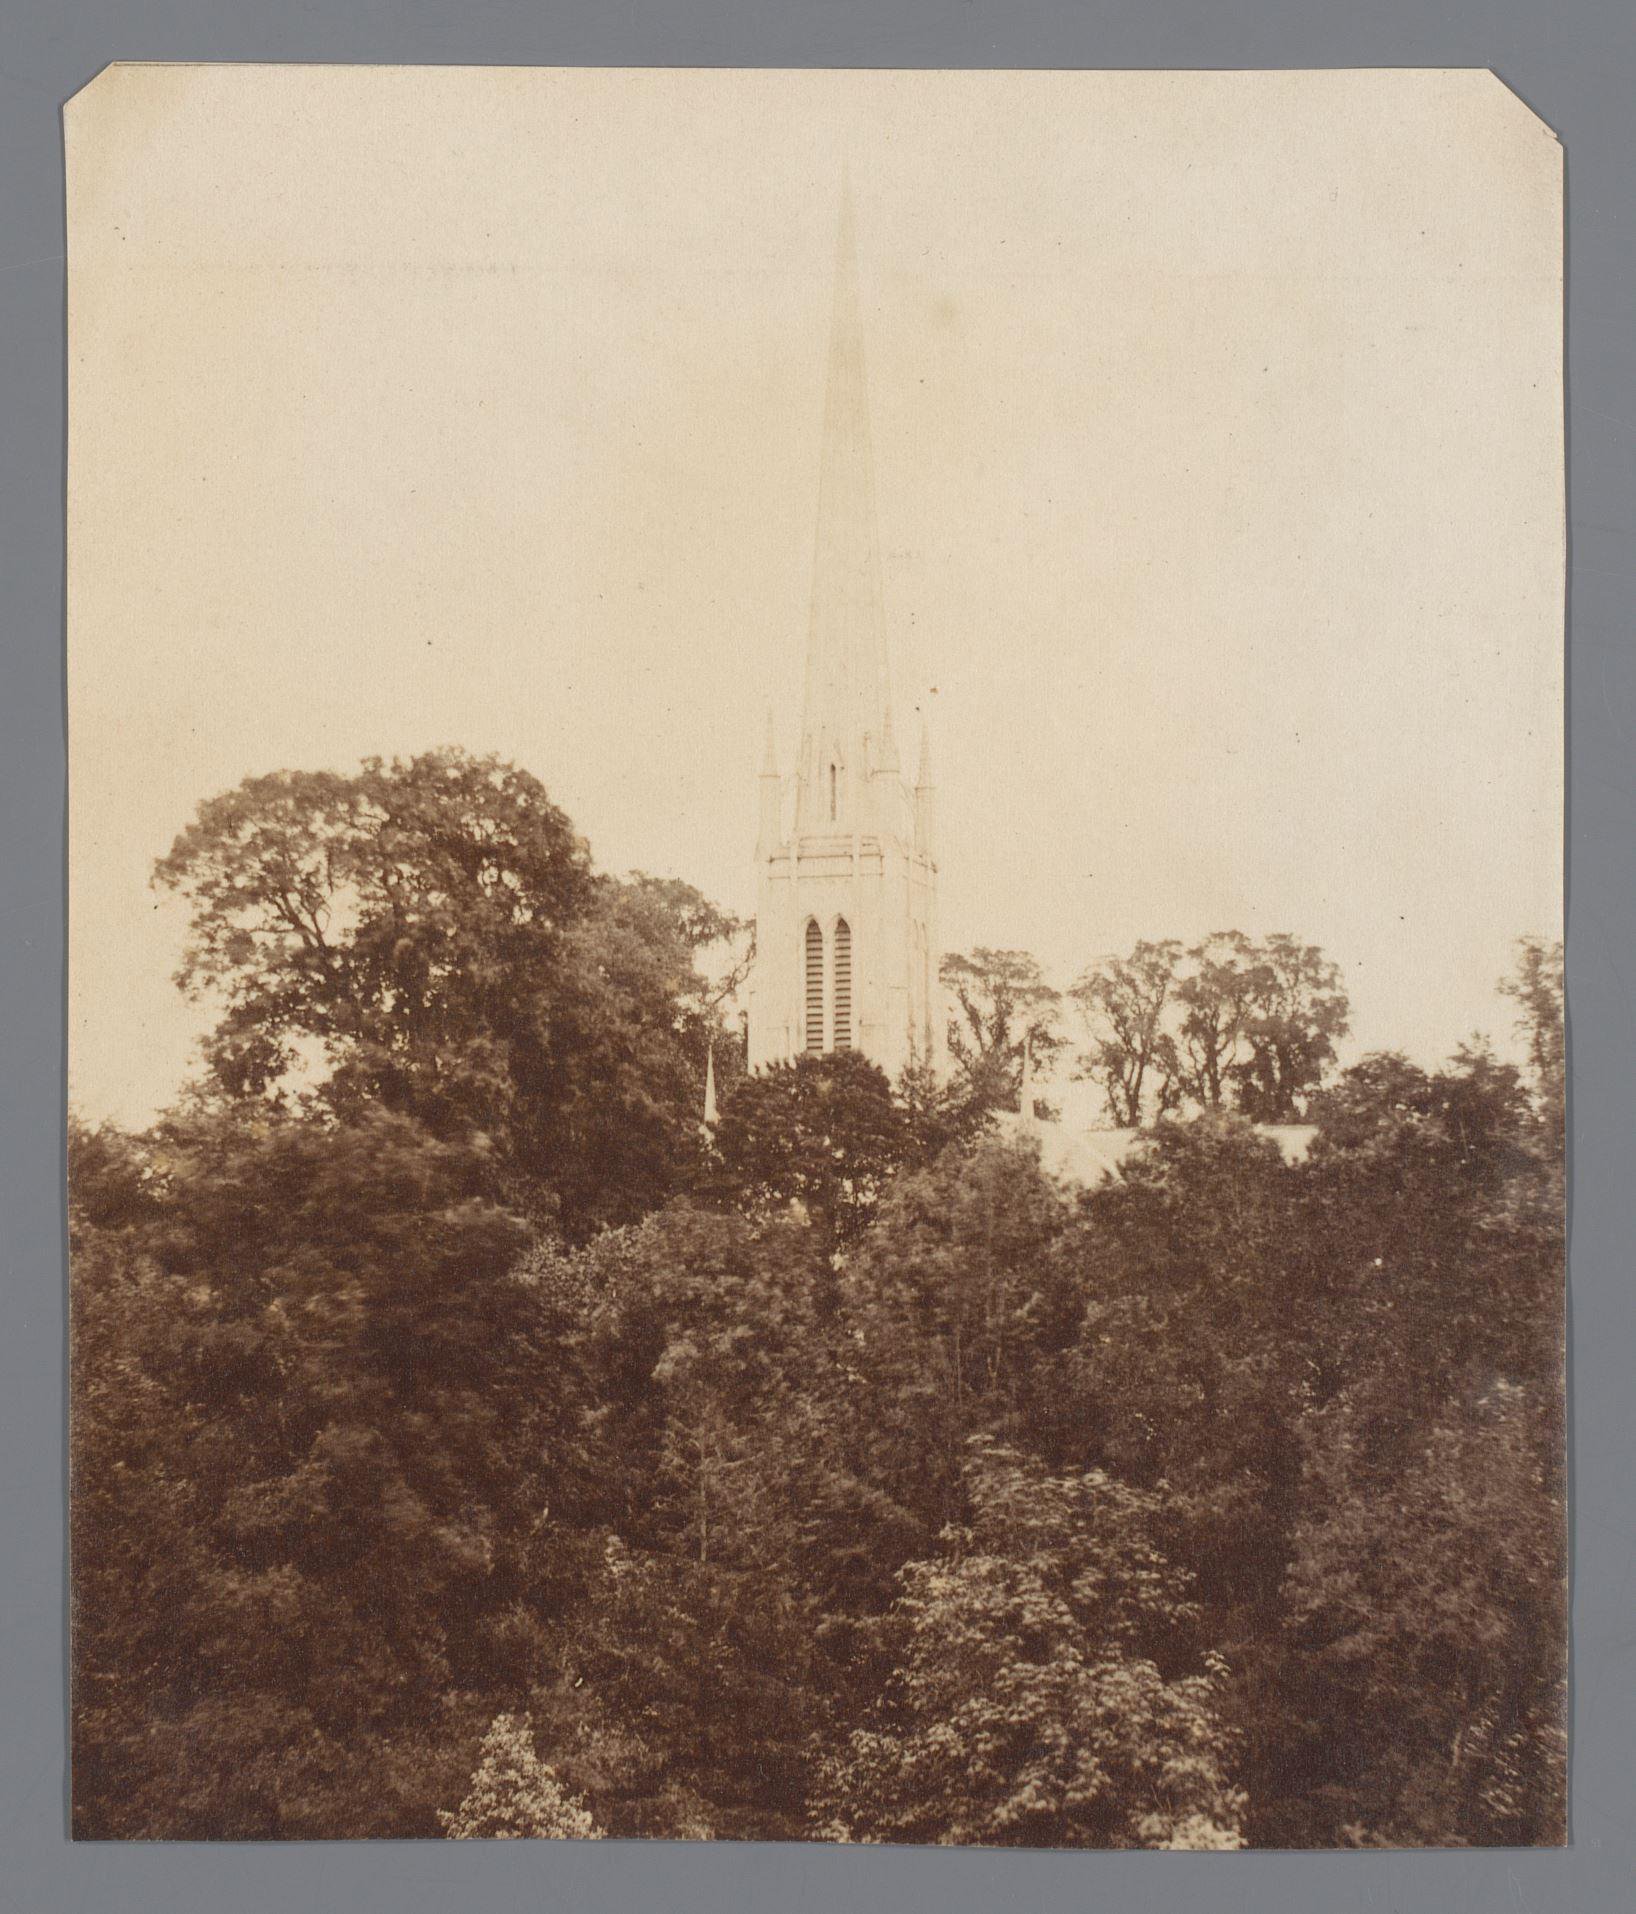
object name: photograph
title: Kerktoren boven de bomen van een bos of park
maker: Anonymous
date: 1875-1890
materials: paper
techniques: albumen print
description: Kerktoren met spits dak boven de bomen van een bos of park.